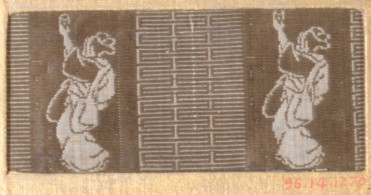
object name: piece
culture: japanese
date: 1701-1900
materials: silk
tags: human figures